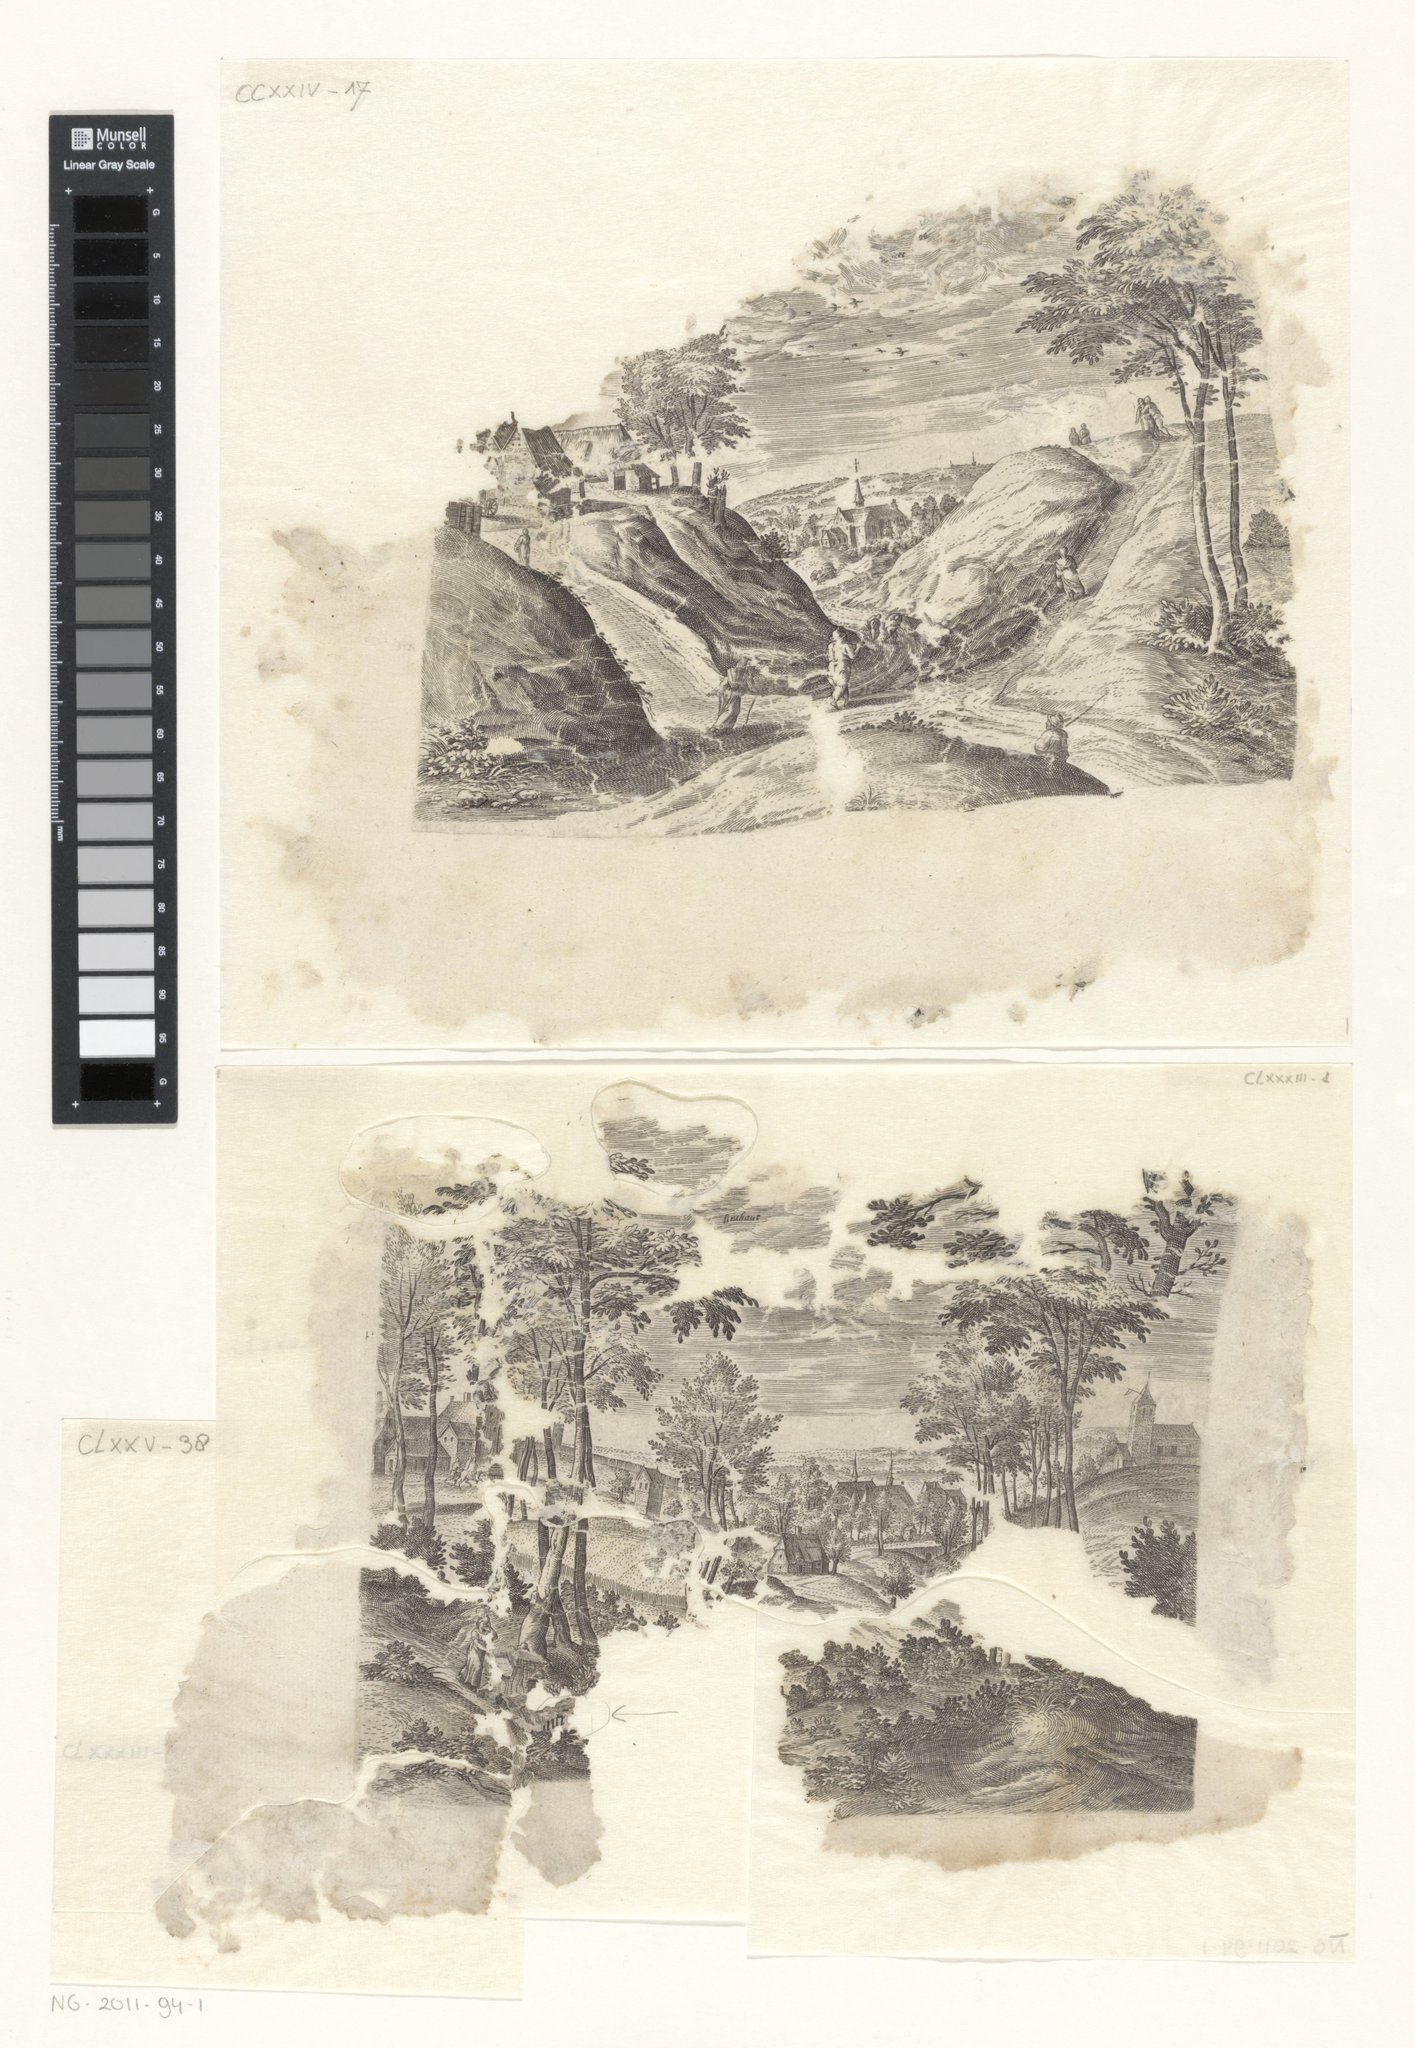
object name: print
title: Landschappen in de omgeving van Brussel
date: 1575-1580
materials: paper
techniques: engraving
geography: southern netherlands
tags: city-view, and landscape with man-made constructions, brussels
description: Prenten zijn onderdeel van een serie van 24. De prenten in de Nova Zembla collectie zijn tijdens een expeditie van Willem Barendsz en Jacob van Heemskerk in 1596-1597 noodgedwongen in het winterkamp, het ‘Behouden Huis’, op het eiland achtergelaten. De prenten waren in één of meerdere stapels als handelswaar meegenomen vanuit Amsterdam. Bijna drie eeuwen later, in 1871, keerde de Noor Elling Carlsen terug naar Nova Zembla en vond daar de restanten van het ‘Behouden Huis, inclusief een groot deel van de inventaris. Een deel van de prenten, in de vorm van aaneengekoekte kluiten, werd toen ook teruggevonden. De papierkluiten waren soms op meerdere plekken gebroken. Tussen 1975-1979 zijn de prenten van elkaar gescheiden. Dit leverde in totaal ca. 1000 fragmenten van ca. 400 afdrukken van ca. 150 verschillende prenten op. Voor zover mogelijk zijn de fragmenten samengevoegd en zijn de prenten gereconstrueerd.